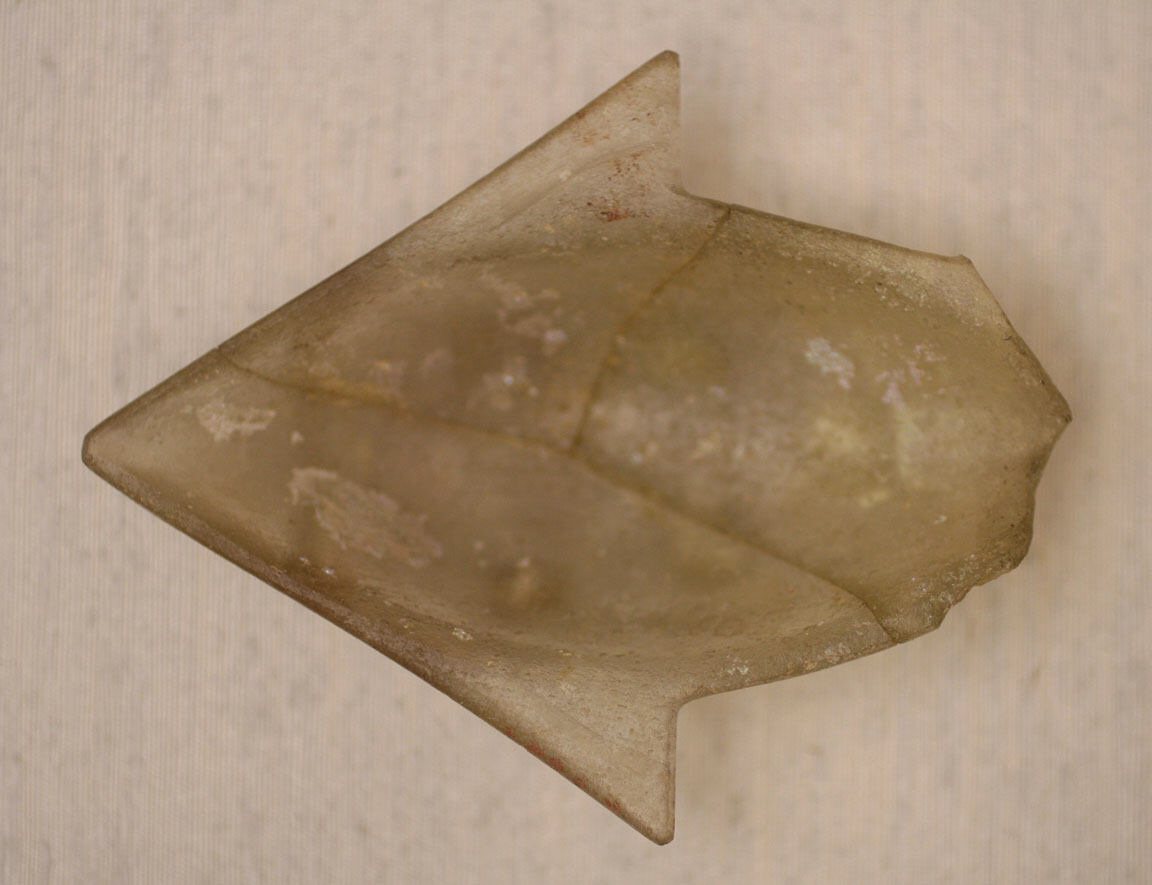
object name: fragment of a dish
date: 901-1200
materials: glass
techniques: cutting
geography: egypt or syria